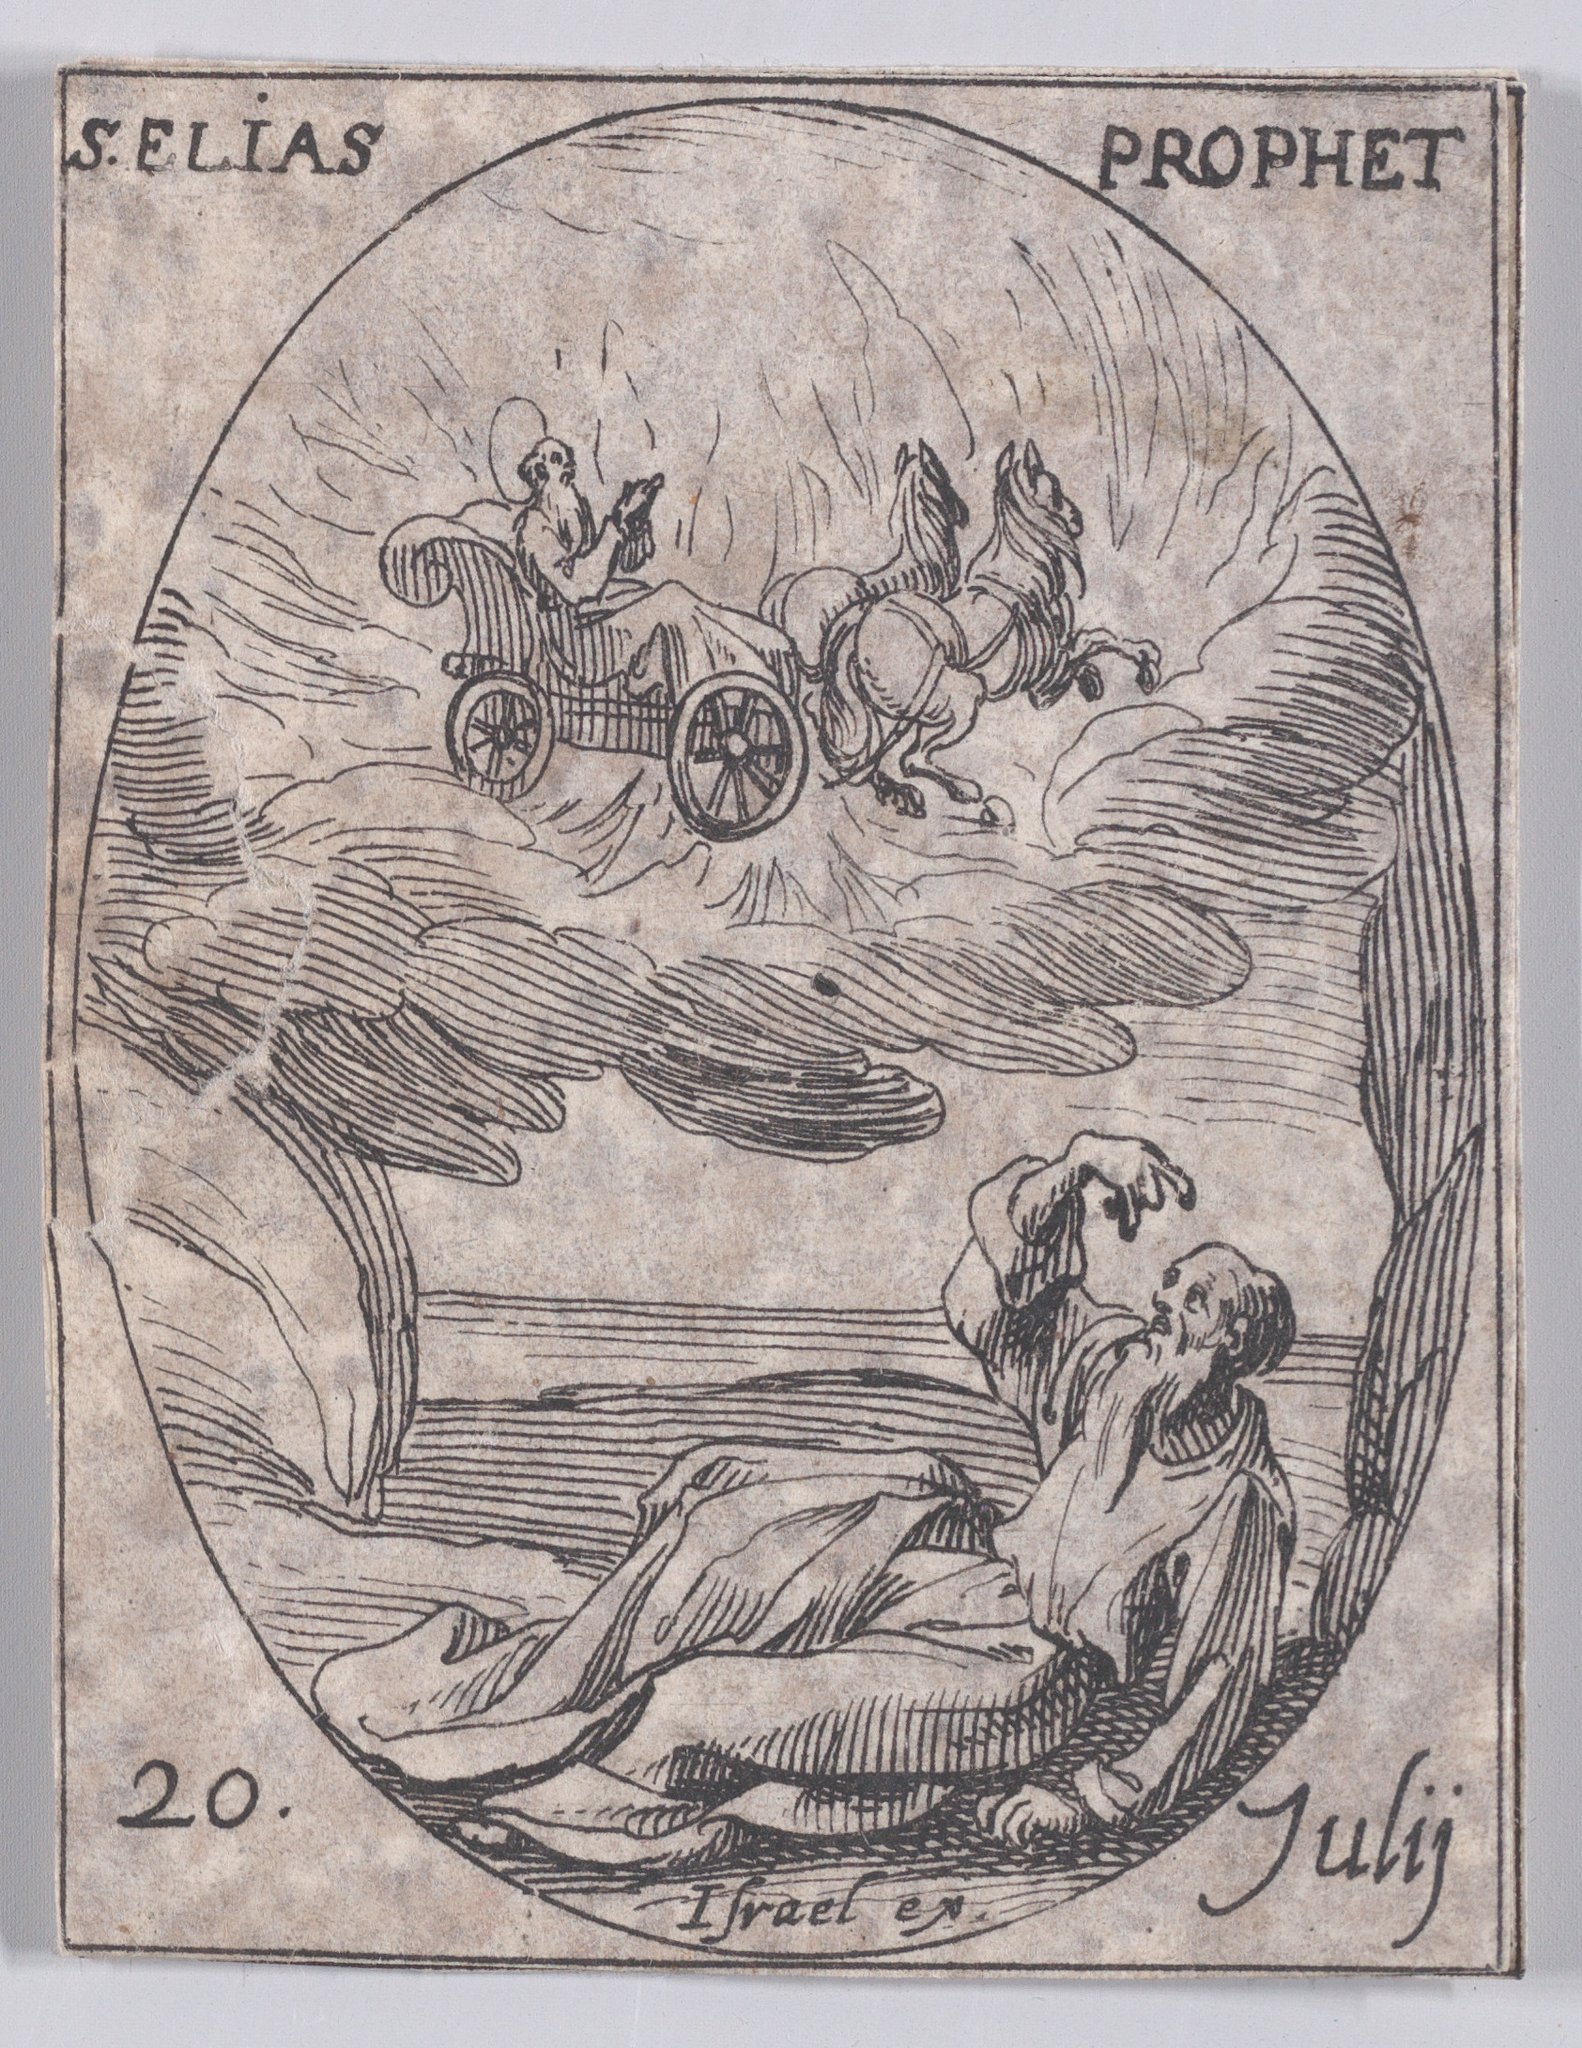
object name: print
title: S. Elie, prophète (St. Elias, Prophet), July 20th, from "Les Images De Tous Les Saincts et Saintes de L'Année" (Images of All of the Saints and Religious Events of the Year)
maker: jacques callot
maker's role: artist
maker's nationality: french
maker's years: 1592-1635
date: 1636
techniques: etching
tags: men,horses,saints,chariots